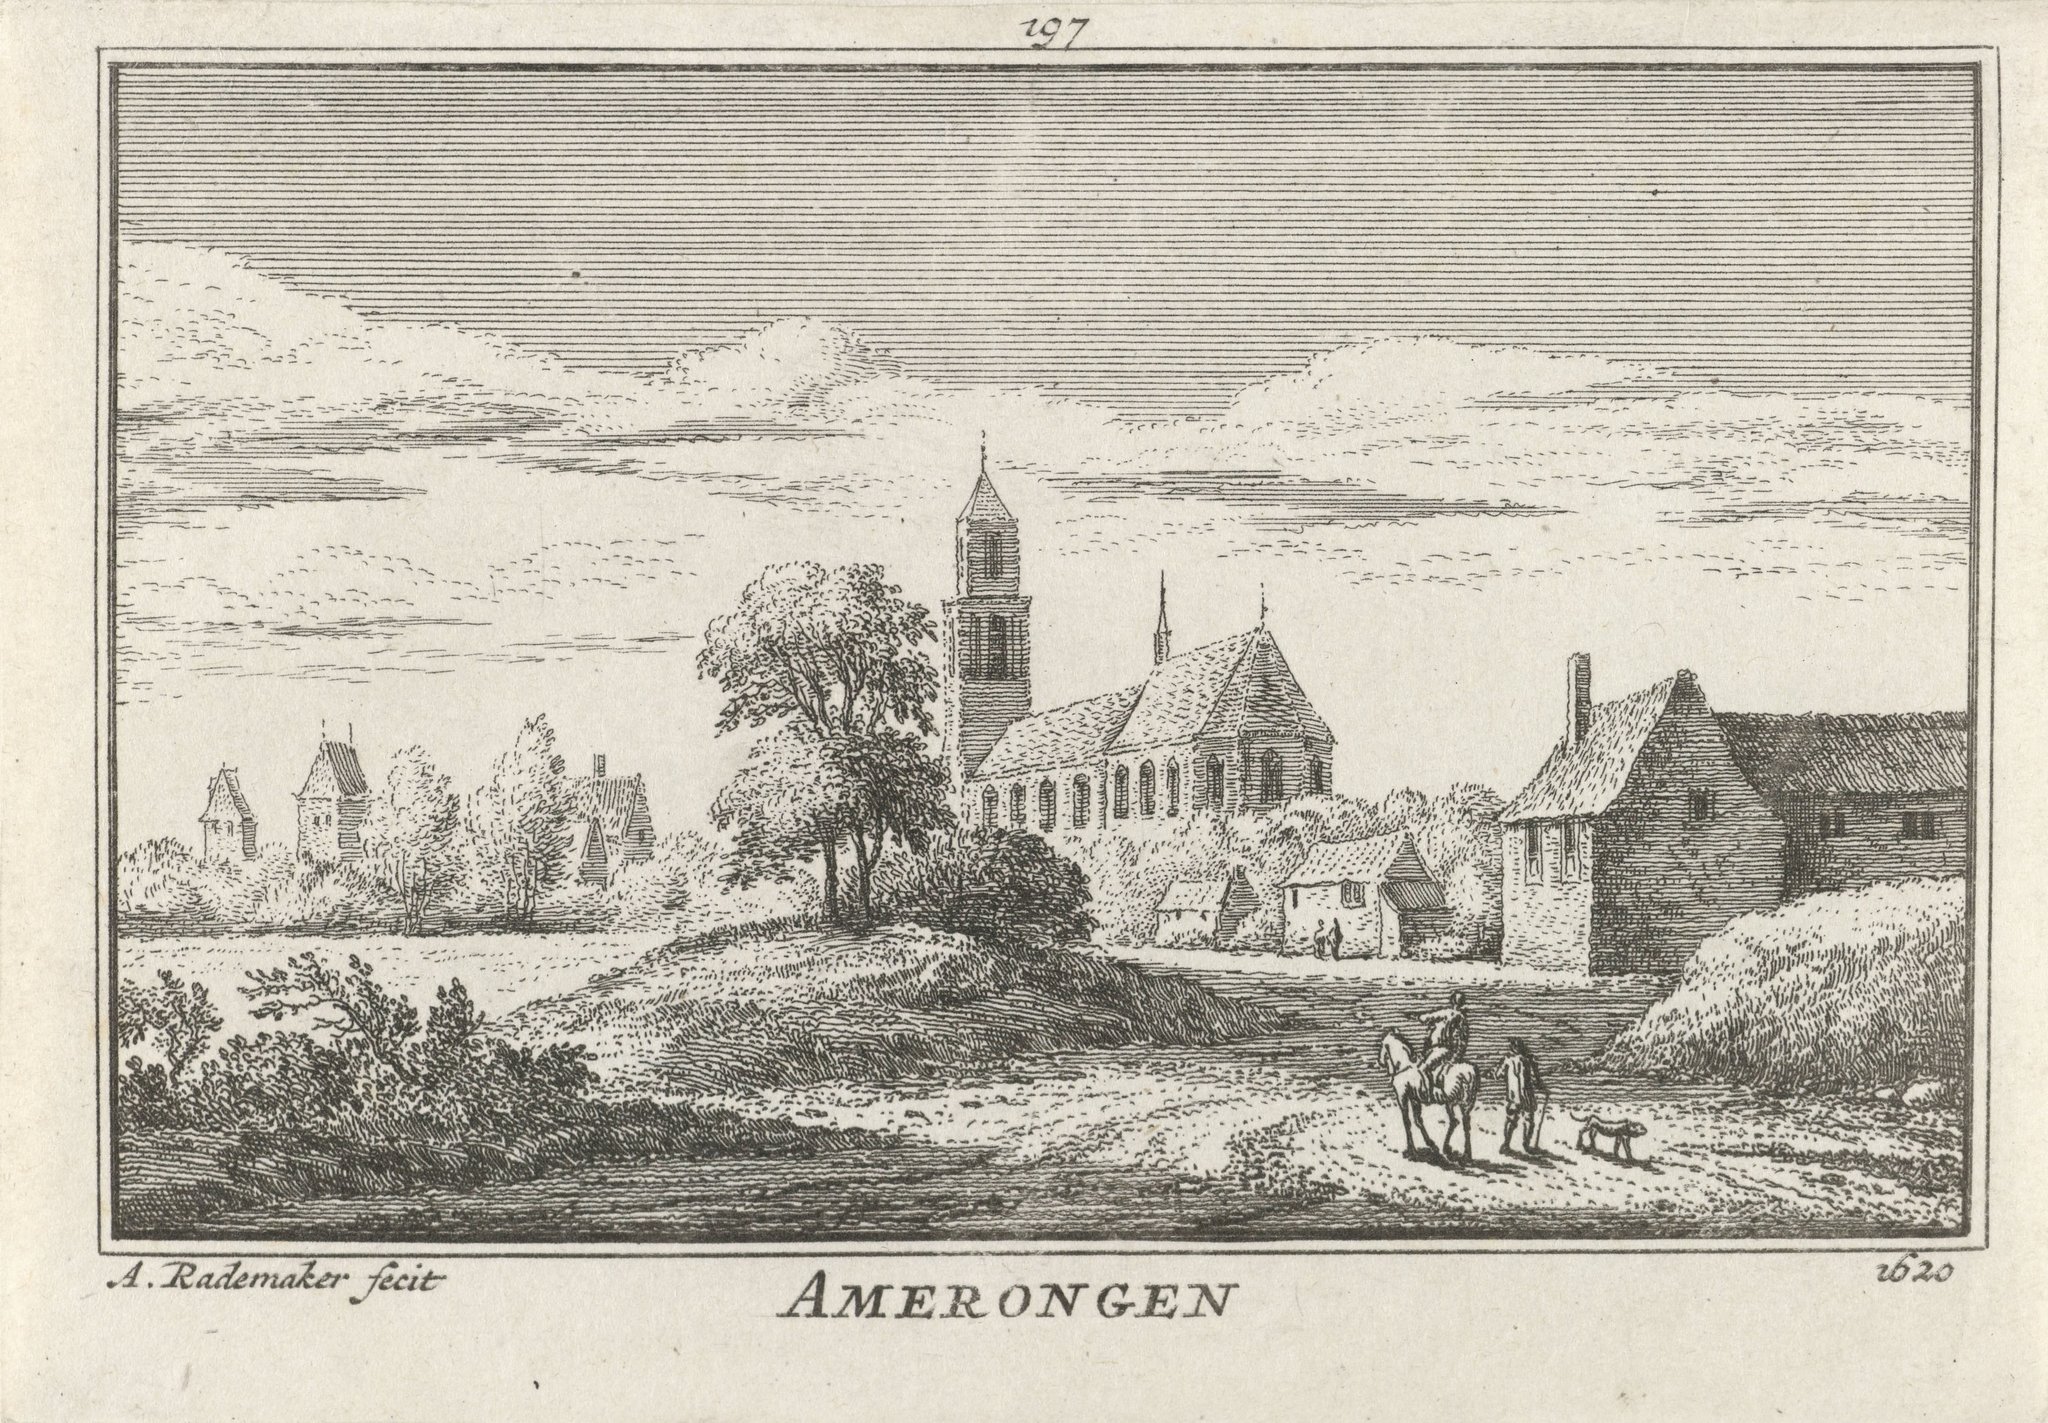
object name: book illustration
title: Gezicht op Amerongen, 1620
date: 1727-1733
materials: paper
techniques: engraving, etching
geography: amsterdam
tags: riding a horse, ass, or mule; rider, horseman, church (exterior), dog, amerongen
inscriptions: collector's mark: Lugt 2228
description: Illustratie uit: Abraham Rademaker, Matthaeus Brouërius van Niedek, Isaac Le Long, Kabinet van Nederlandsche en Kleefsche outheden en (...) voorname stads- en landgebouwen, Willem Barents en Antoni Schoonenburg: Amsterdam, 1727-1733, ill. nr. 197.